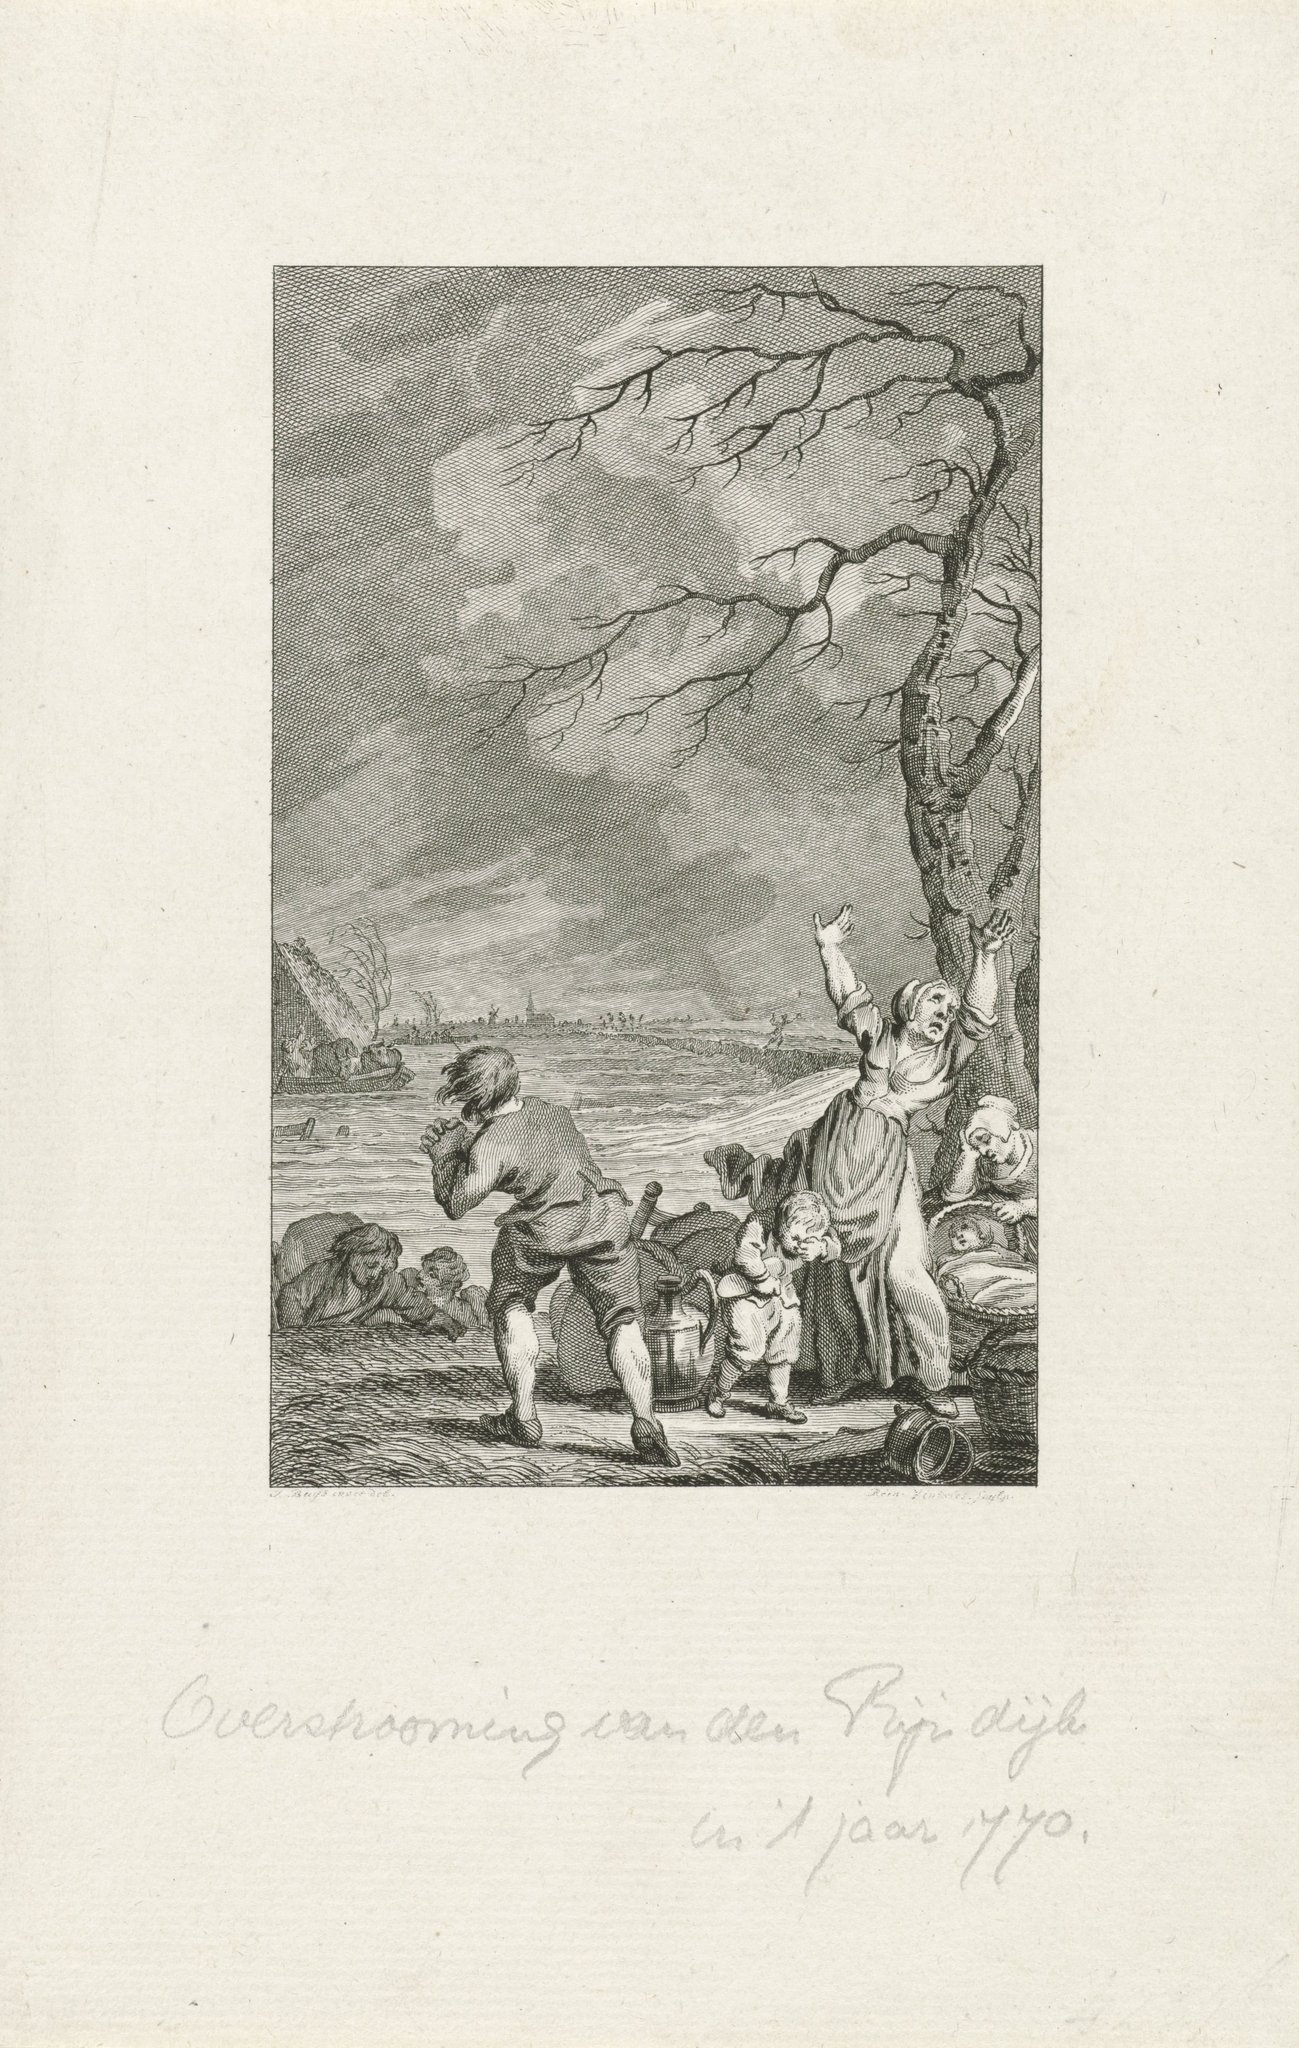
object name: print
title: Overstroming van de Rijndijk in Gelderland, 1770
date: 1789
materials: paper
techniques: etching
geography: northern netherlands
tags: dike-break, gelderland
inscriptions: collector's mark: Lugt 2228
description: Gebruikt als illustratie in: P.A. Loosjes, Vaderlandsche historie, vervattende de geschiedenissen, der Vereenigde Nederlanden (...). Vier-en-twintigste deel. Beginnende met den jaare 1766 en eindigende met den jaare 1774, bevattende het tydperk der meerderjaarigheid des erfstadhouders Willem den V, tot de Americaensche onlusten. Ten onmiddelyken vervolge van Wagenaar's Vaderlandsche historie. Amsterdam: Johannes Allart, 1789.